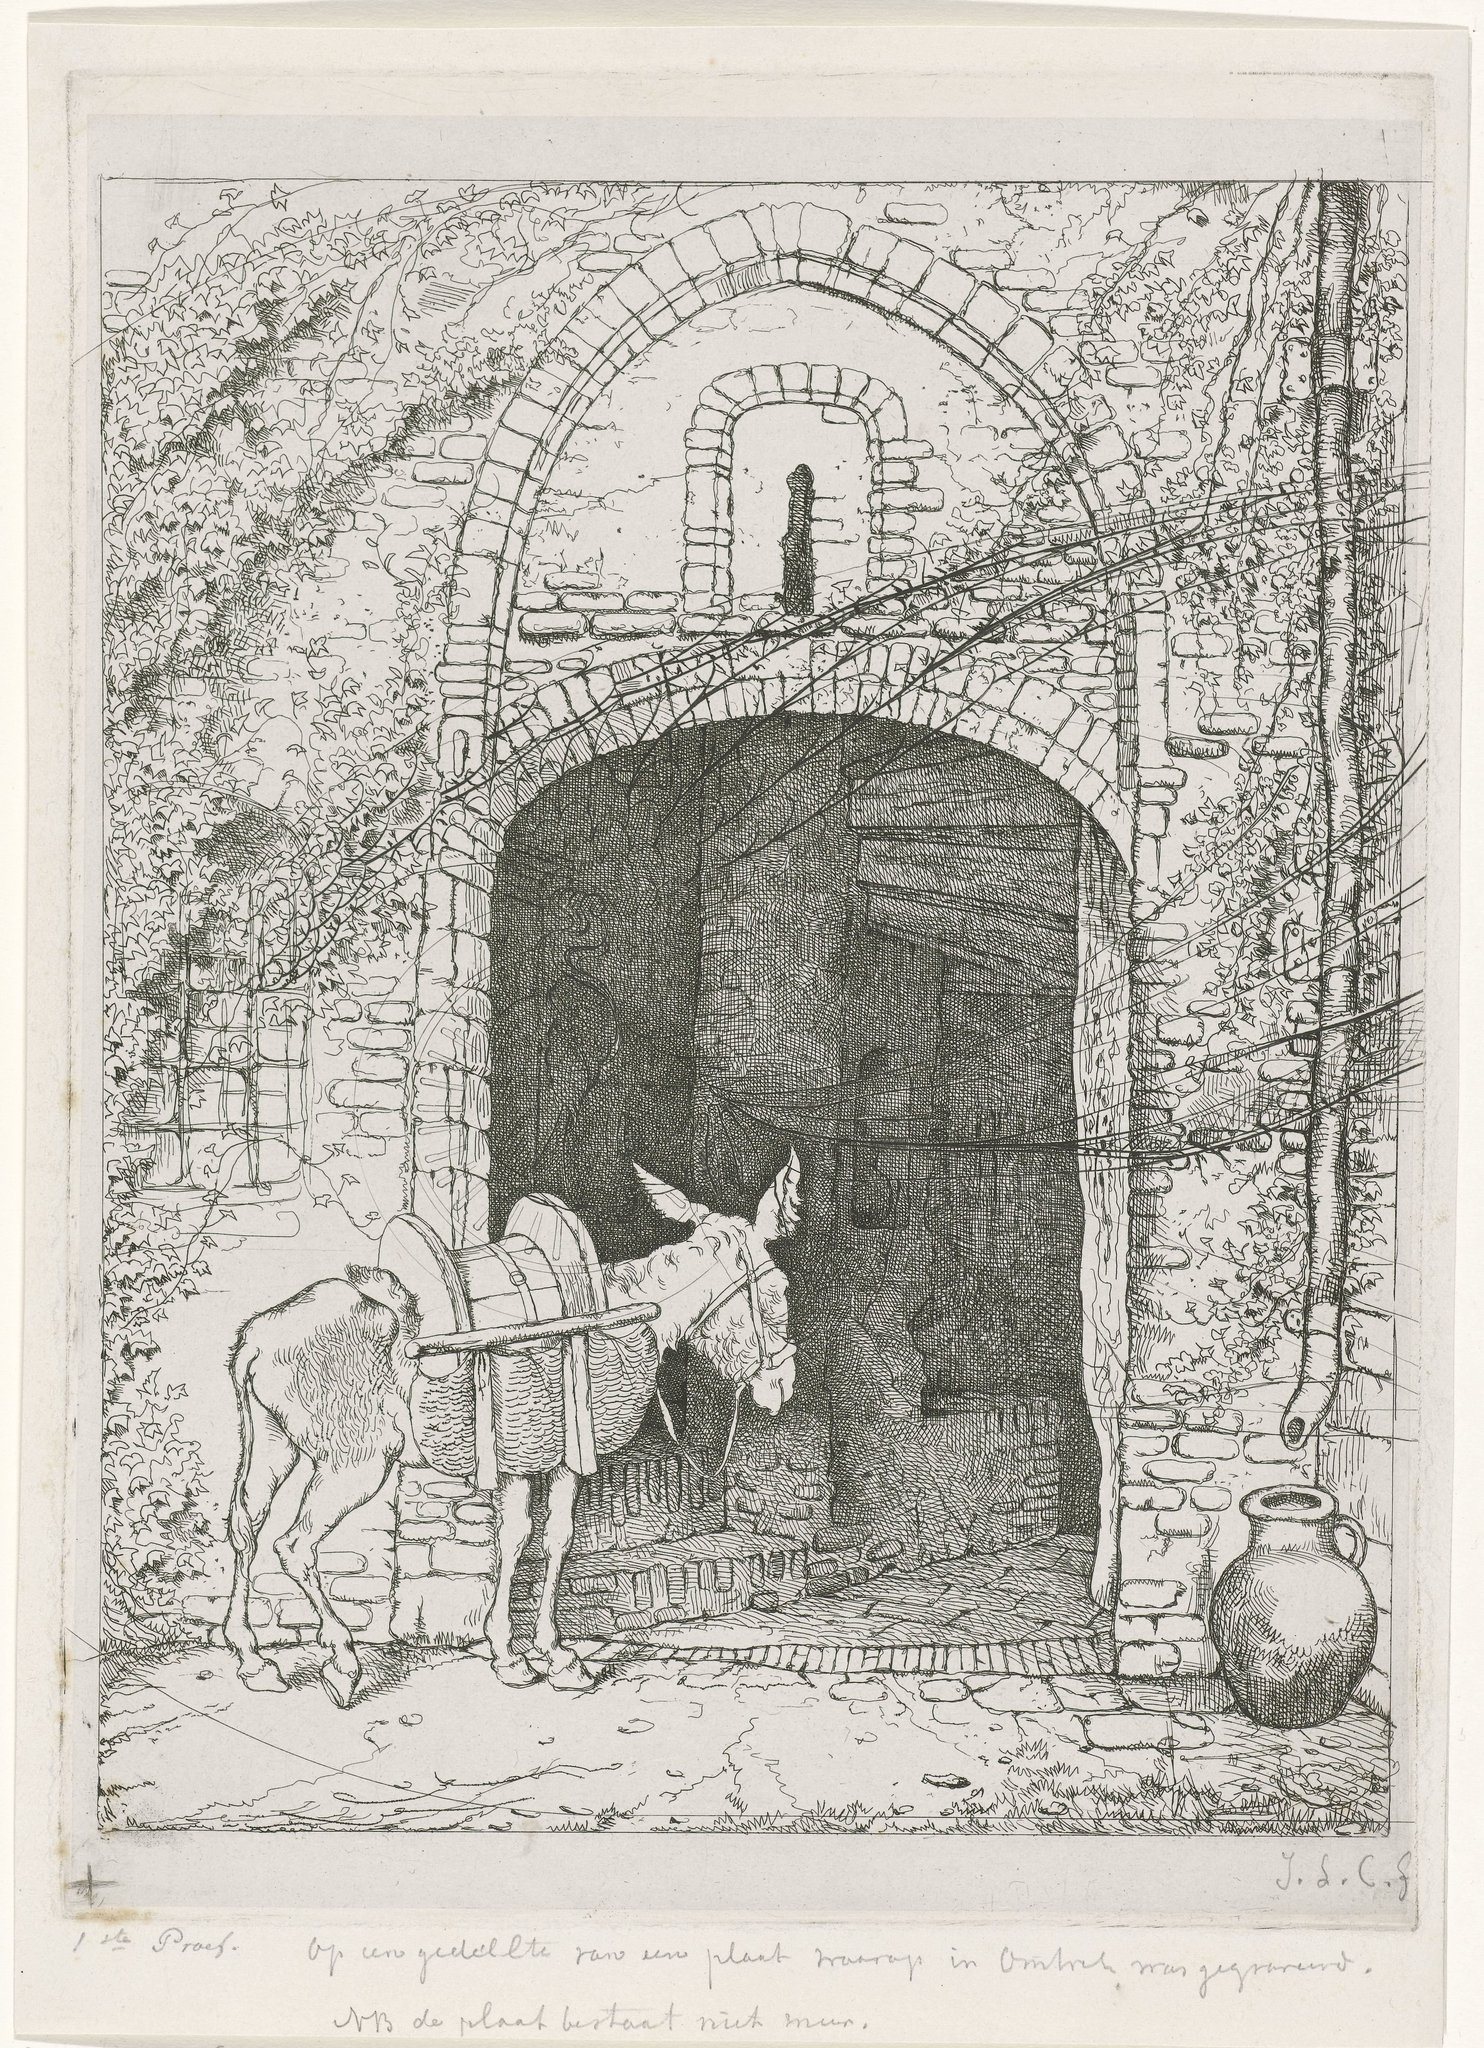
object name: print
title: Ezel voor zijn stal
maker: jacobus ludovicus cornet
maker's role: draughtsman, print maker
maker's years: 1815-1882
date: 1825-1882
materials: paper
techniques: etching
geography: leiden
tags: barn, ass, donkey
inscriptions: collector's mark: Lugt 2228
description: Een ezel staat voor de poort van zijn stal. In de rechterhoek een waterkruik. De prent is geëtst op een al eerder gebruikte plaat van een engel.